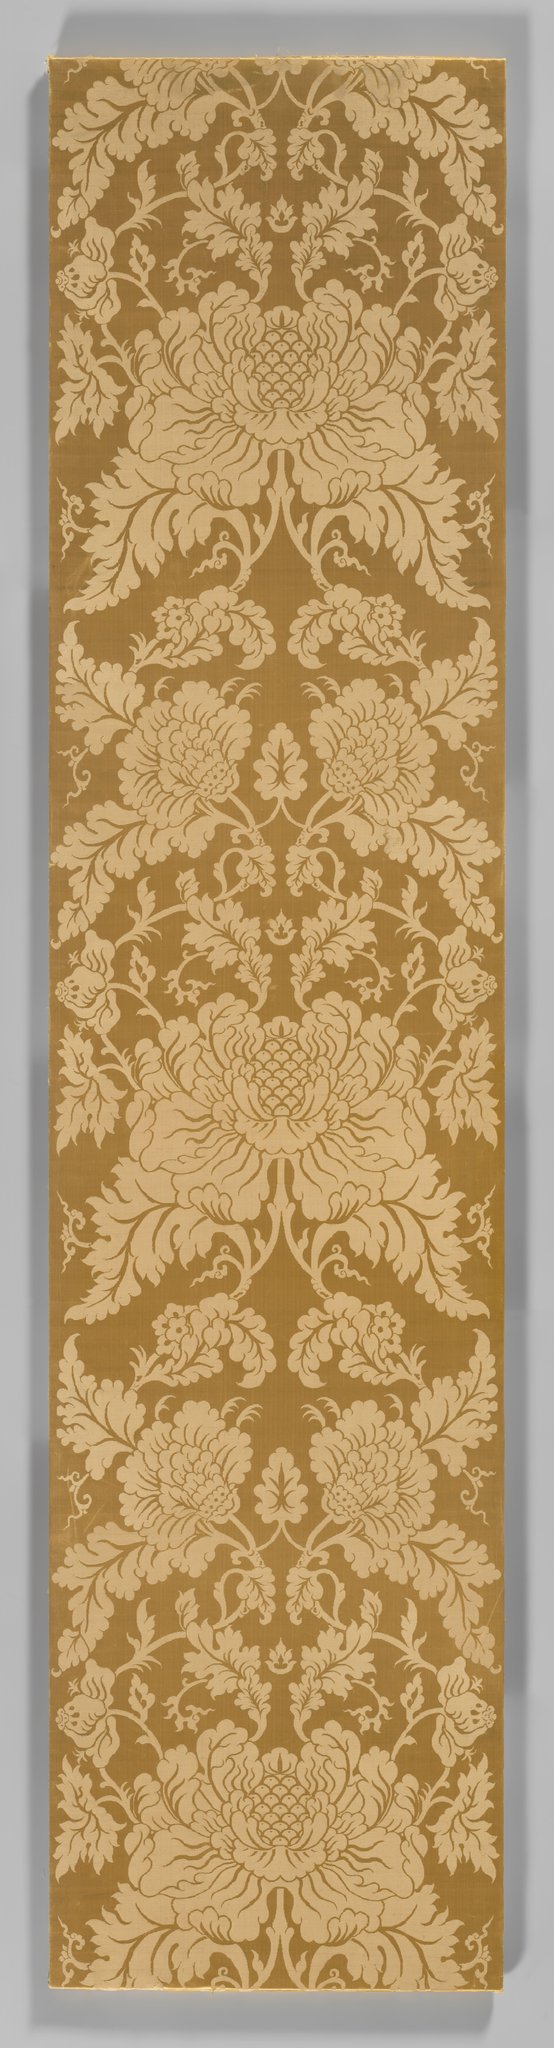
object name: upholstered wall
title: Wandbespanning van geel zijden damasten met symmetrisch patroon van twee opgaande golvende ranken met onder andere pioenvormige bloemen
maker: Anonymous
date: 1700-1725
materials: silk, wood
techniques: damask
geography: france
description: Geel zijden damasten wandbespanning. Symmetrisch patroon van twee opgaande golvende ranken waaraan grote pioenvormige bloemen met geschubtd hart; kleinere bloemen zijn paarsgewijs geplaatst, evenals bloemknoppen, gevederde bladeren en arabeskrankjes, die eindigen in wolkenbanden. Patroon van keperstreep, fond van satijnbinding. Afkomstig uit het pand Voorstraat 140 te Dordrecht. Eén baan heeft aan de onderkant wat waterschade.